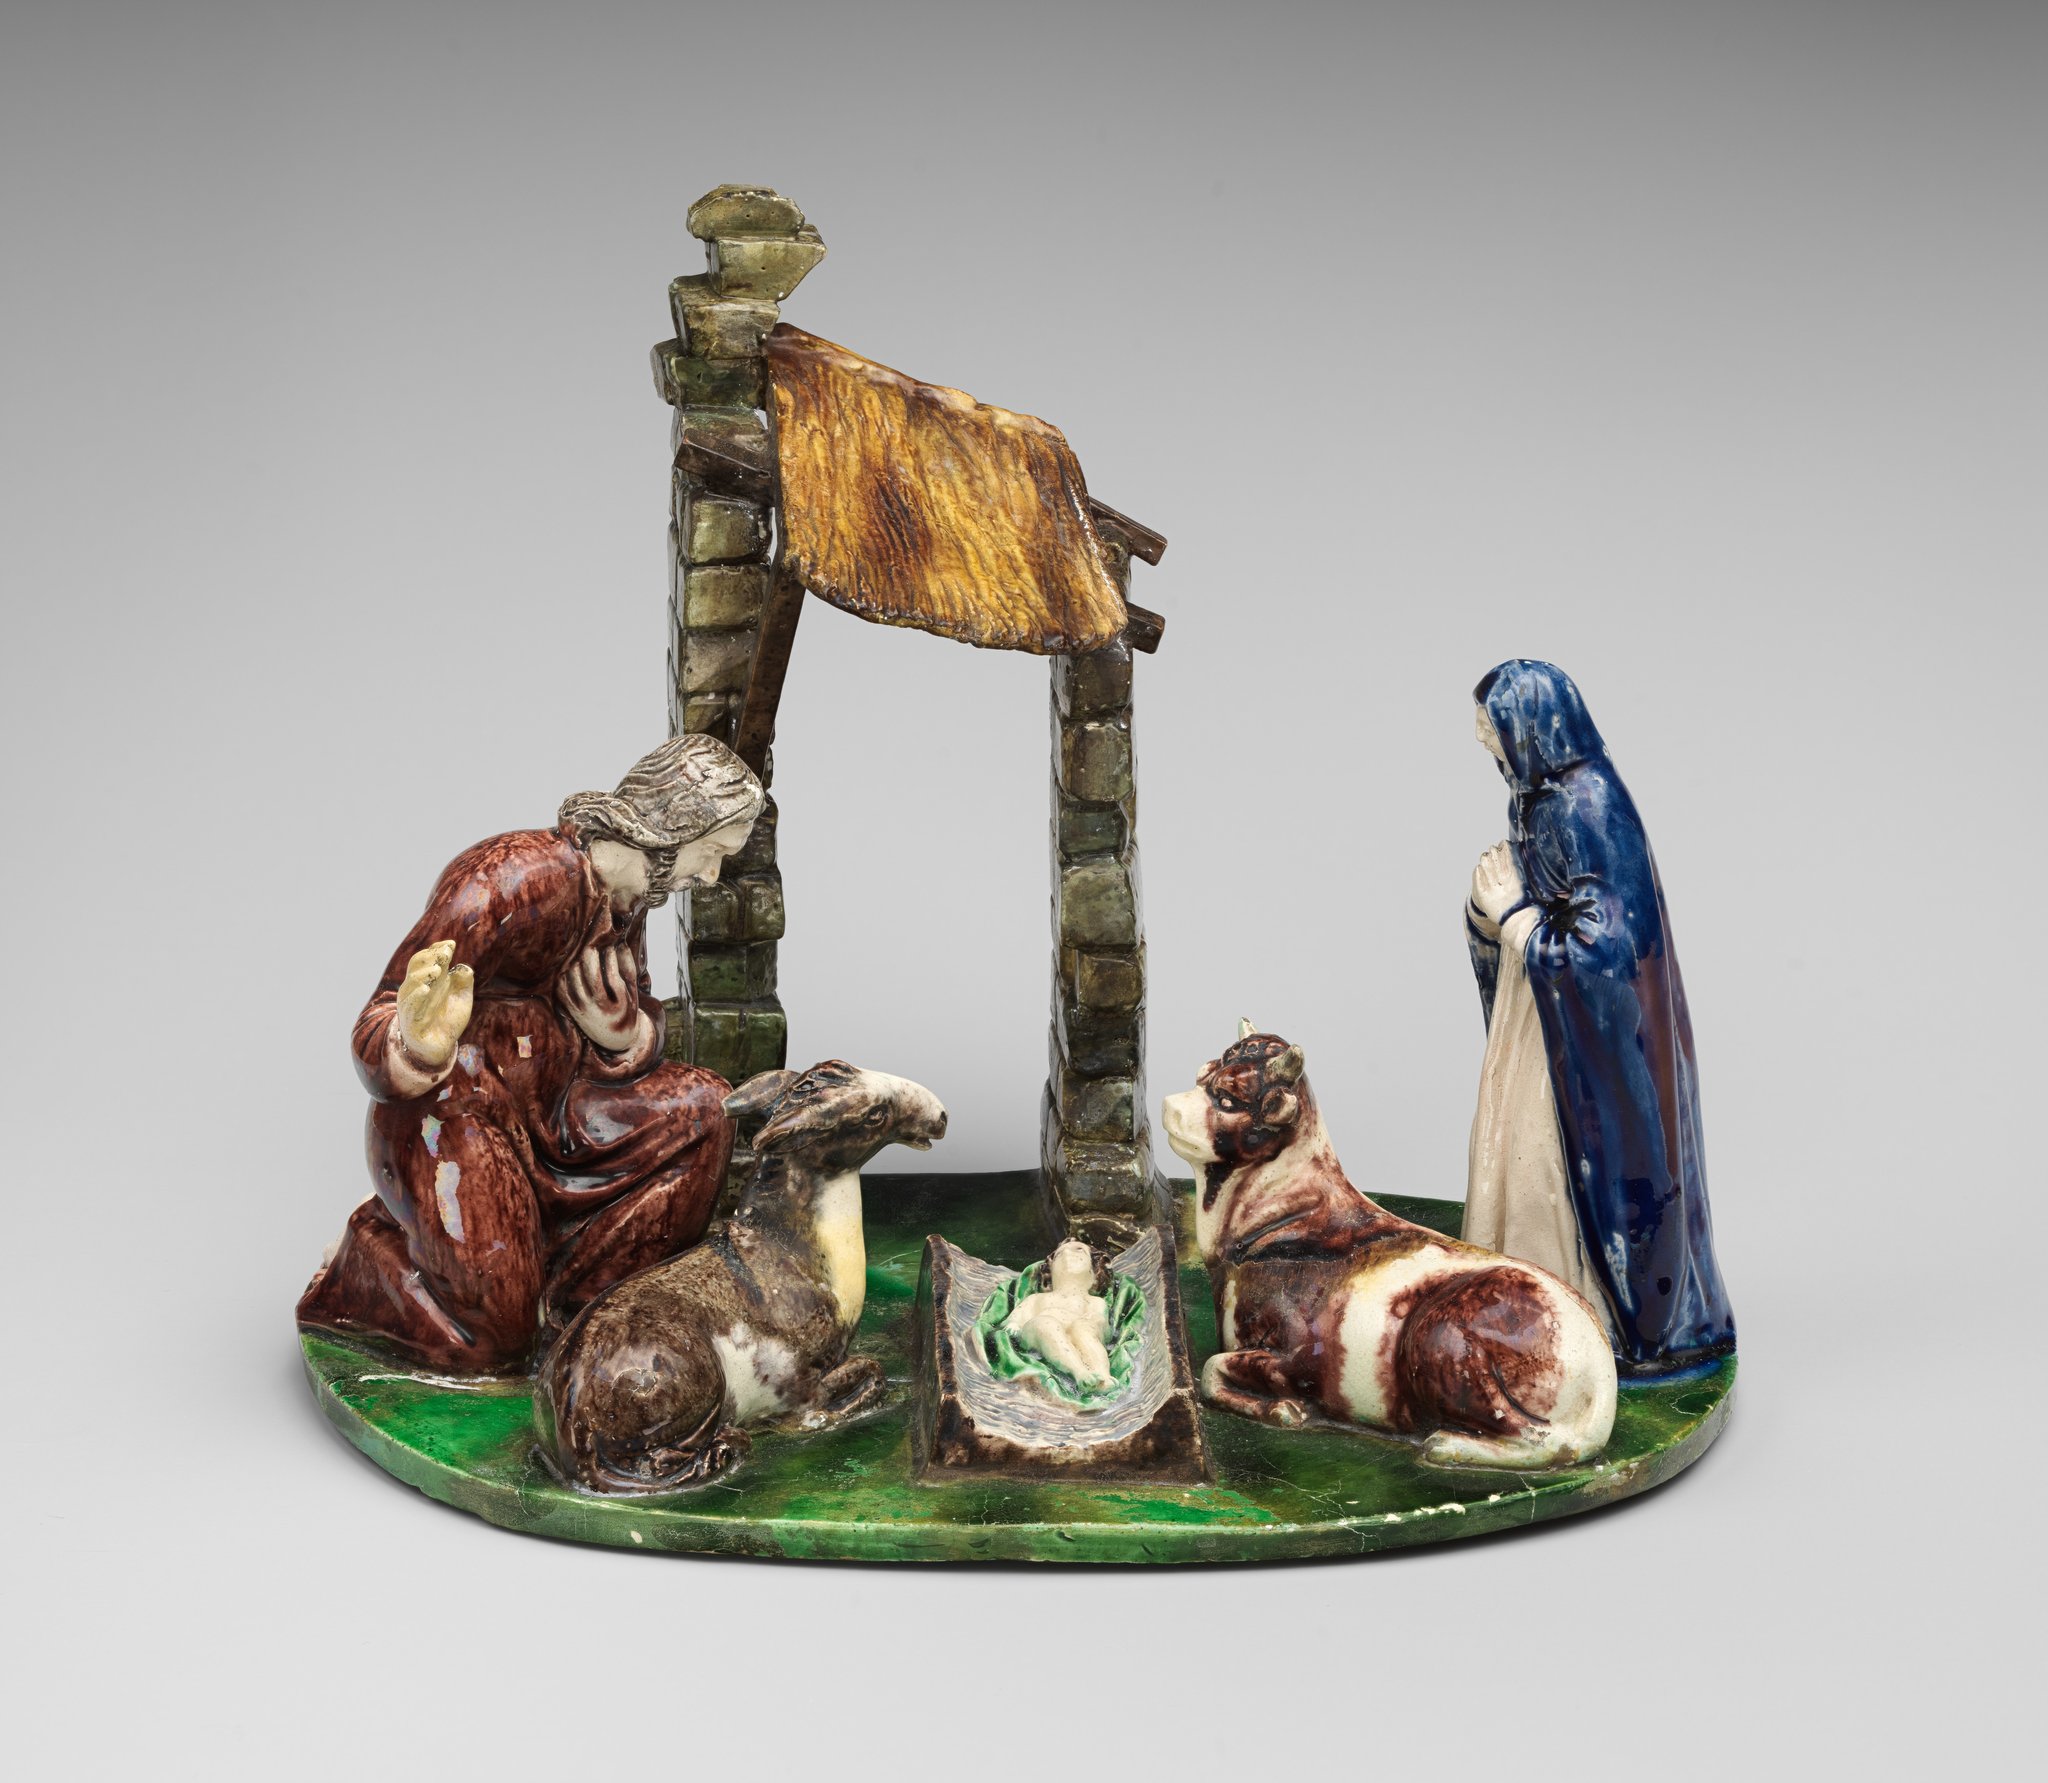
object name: group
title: The Nativity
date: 1601-1650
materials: earthenware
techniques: glazing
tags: sheep,christ,virgin mary,nativity